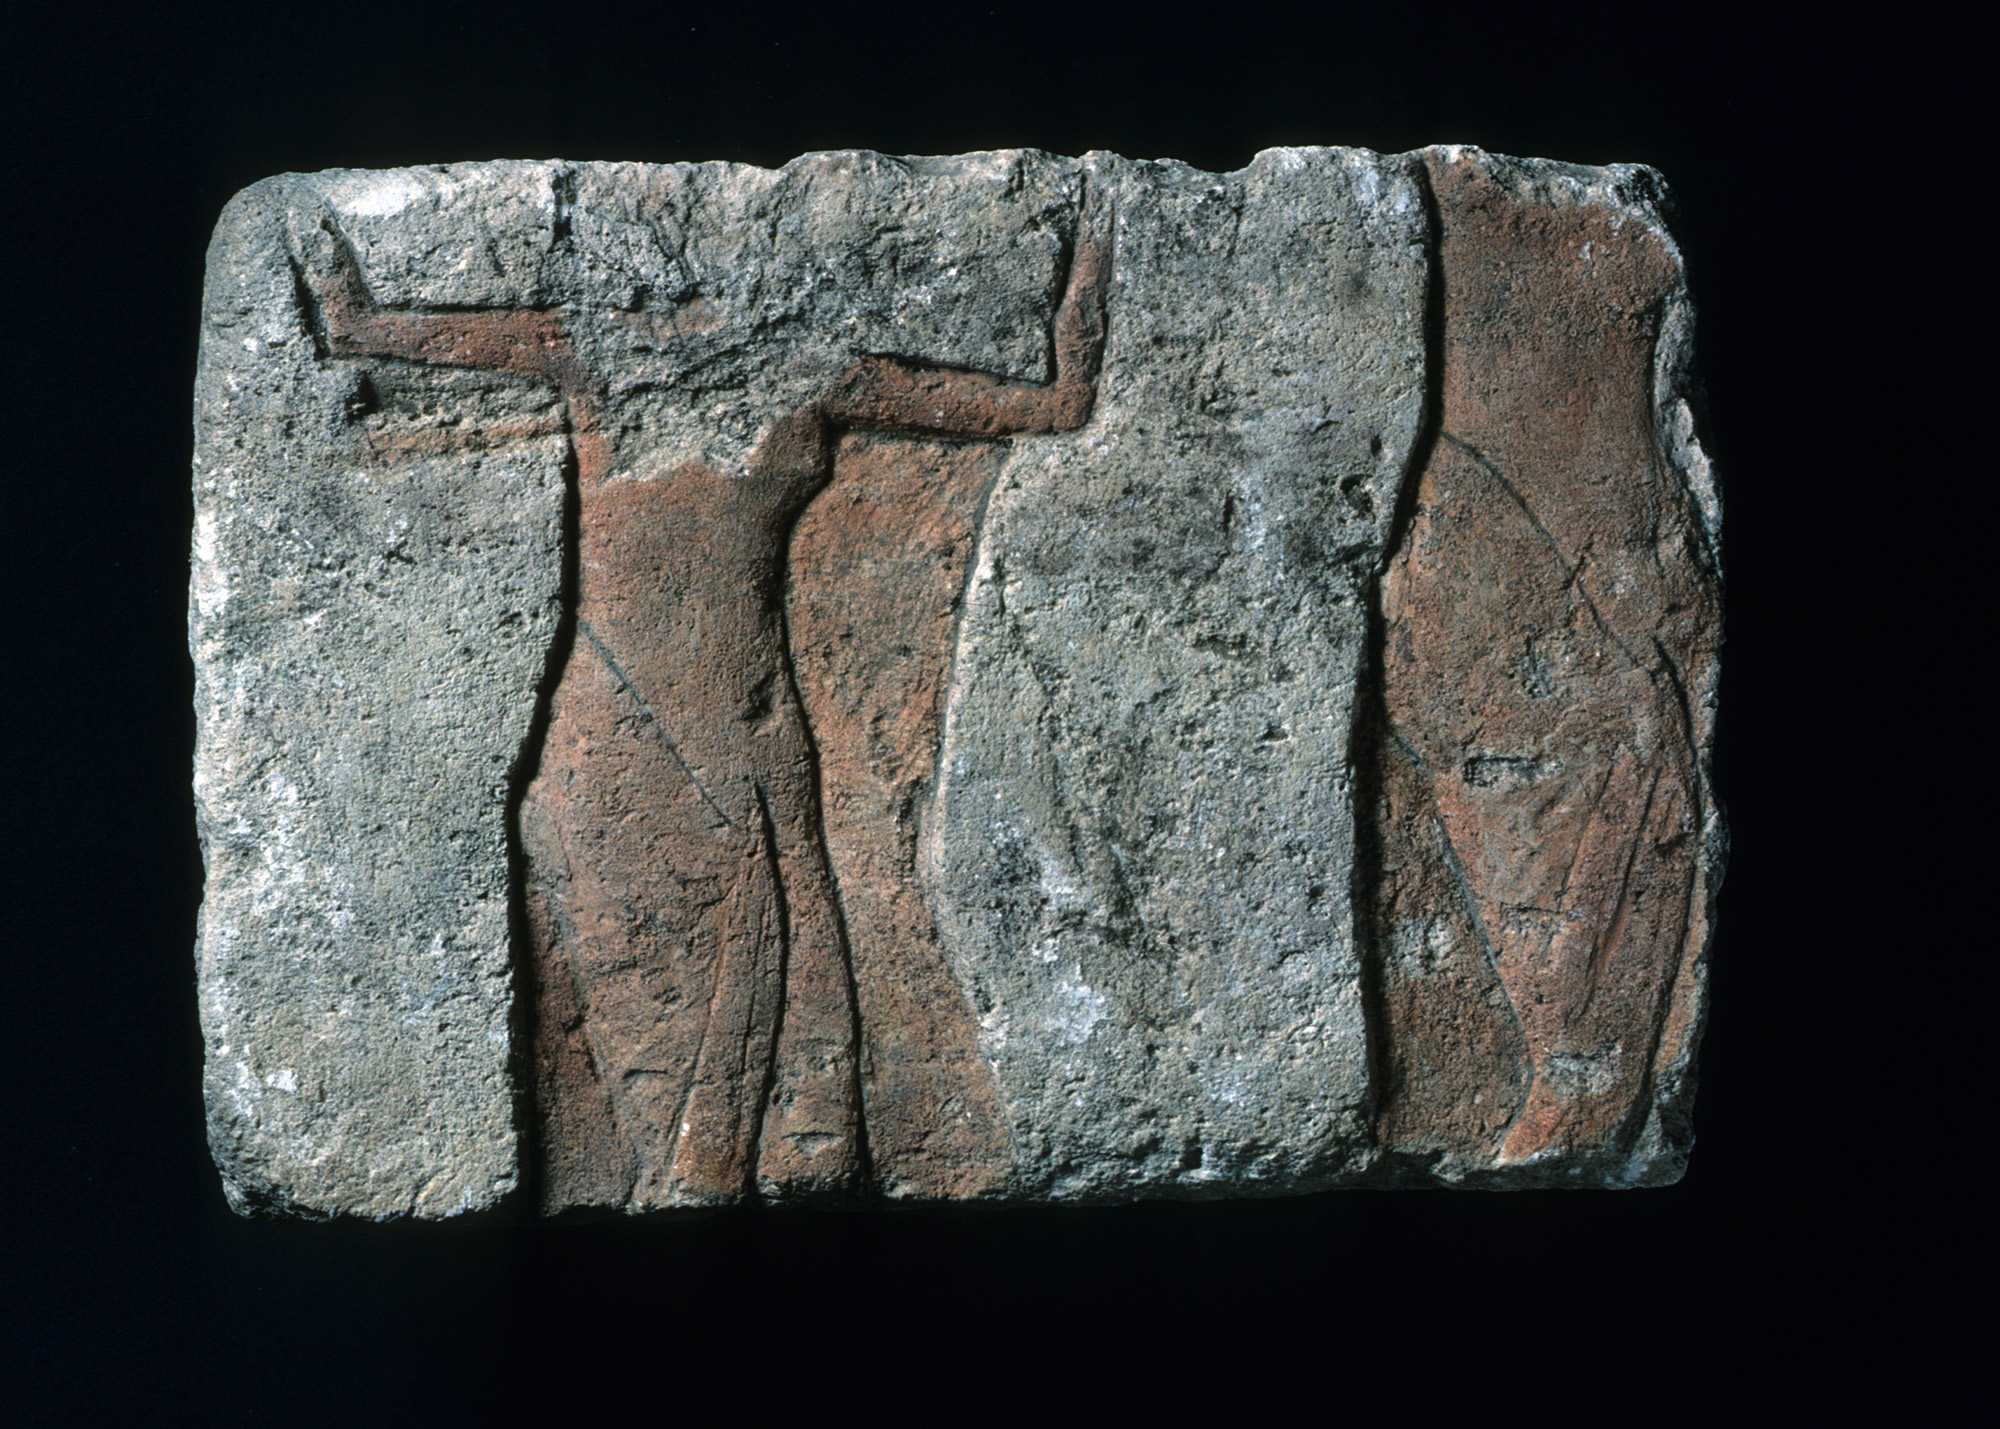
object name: talatat, male figure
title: Relief fragment with a male figure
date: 1353-1336 BCE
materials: limestone, paint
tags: men